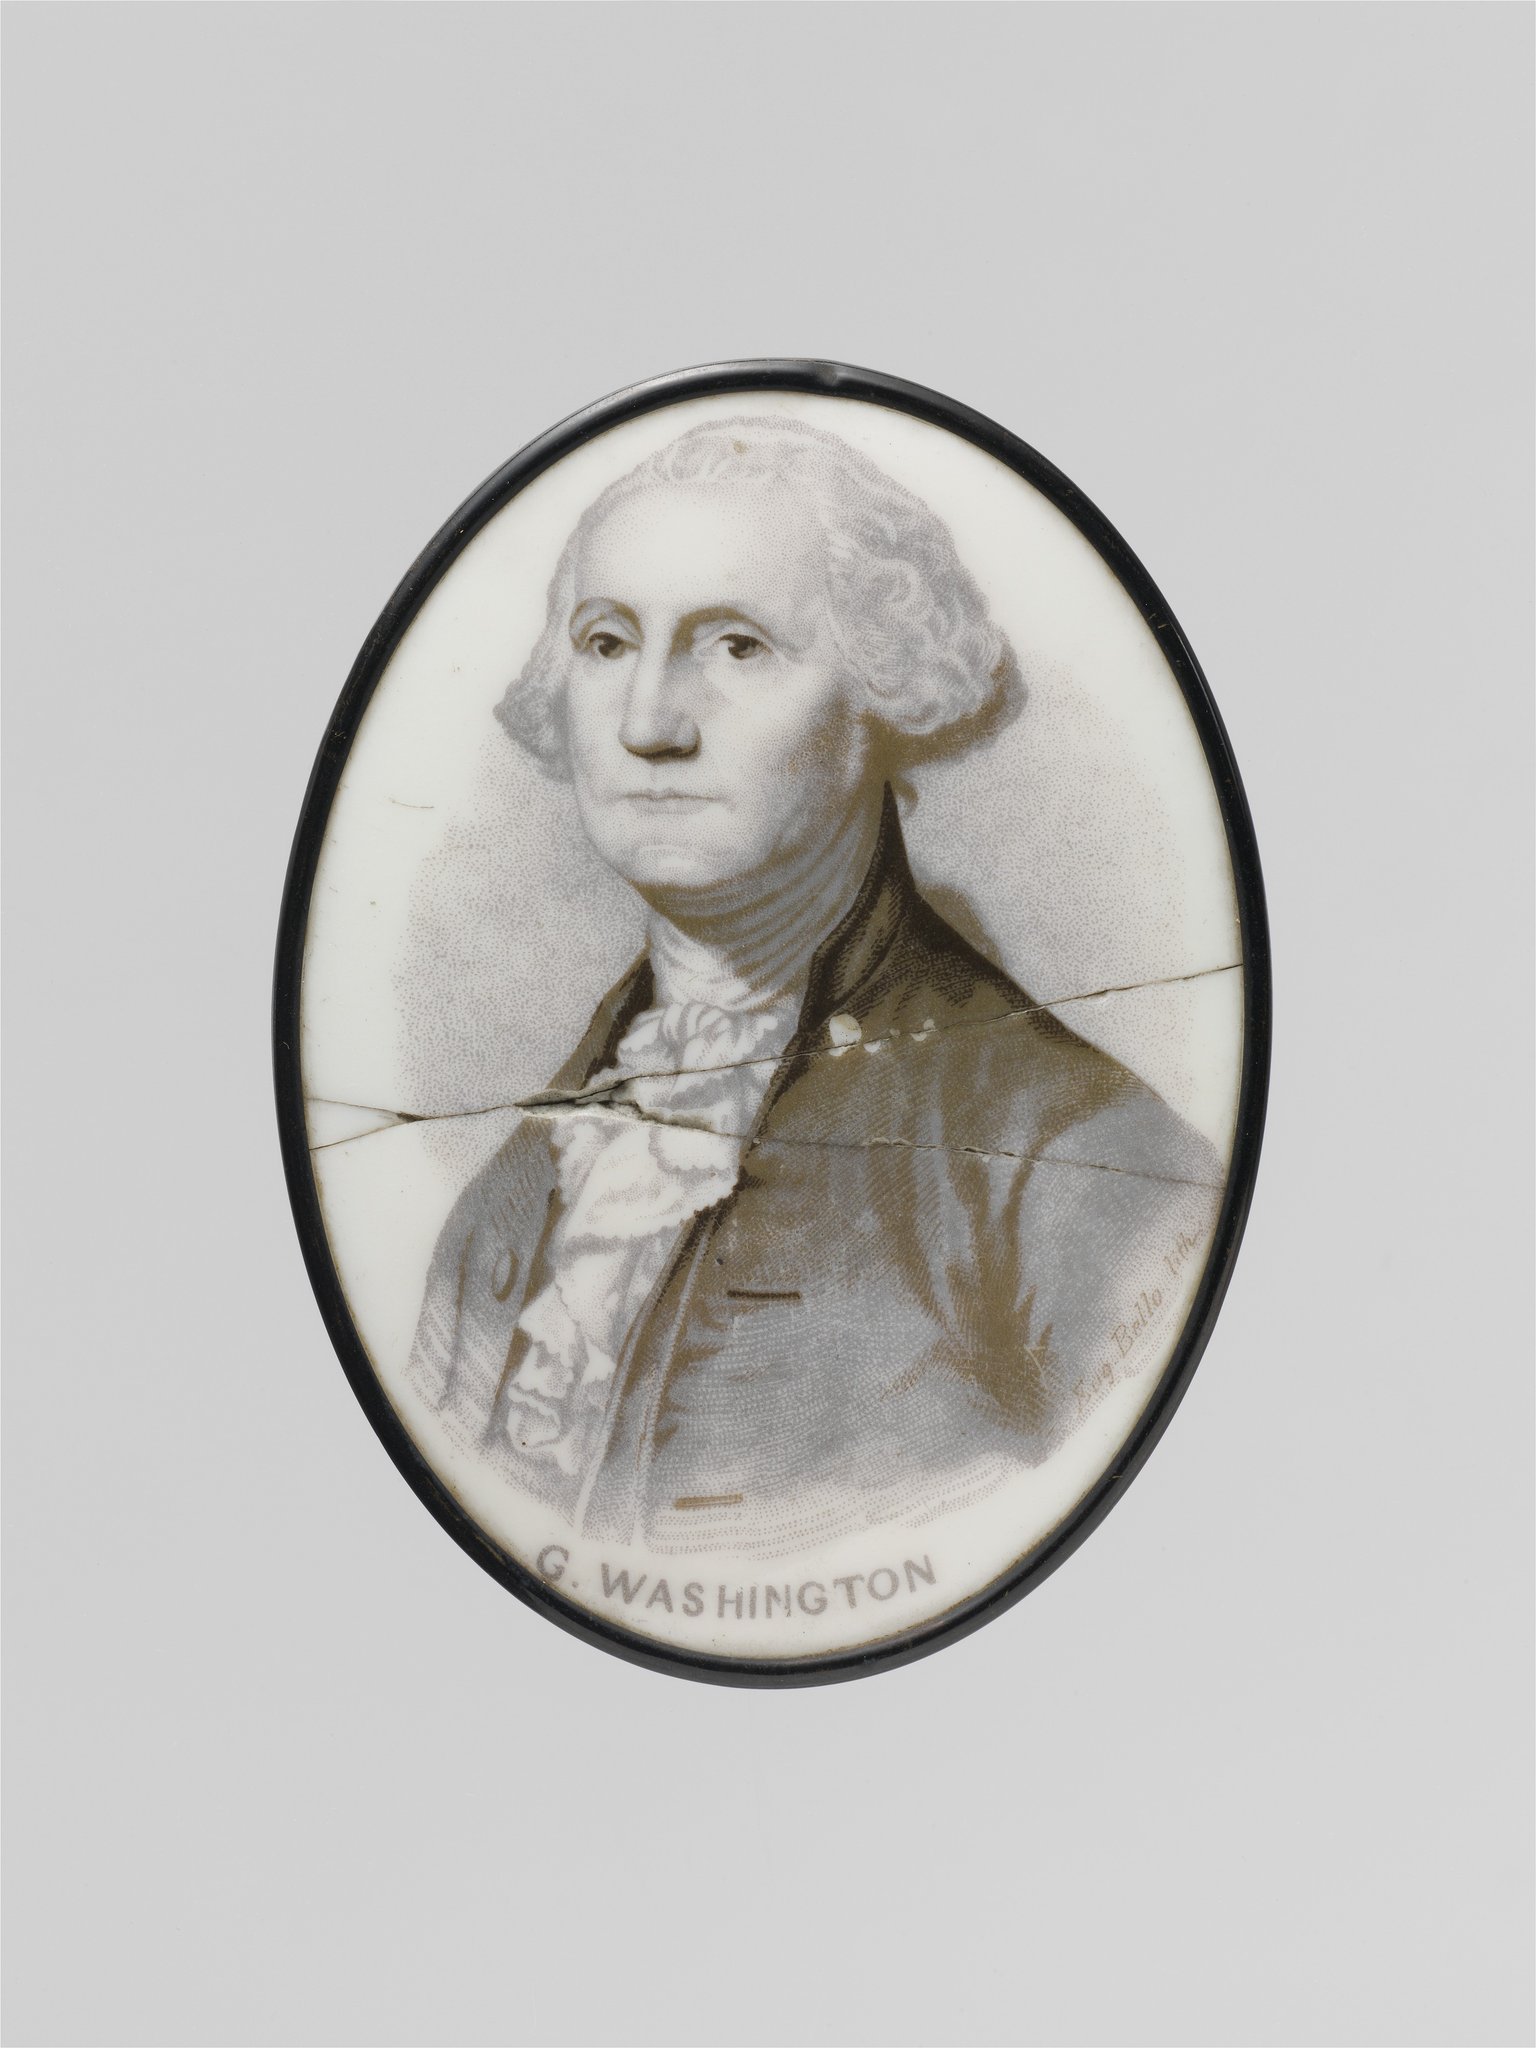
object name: plaque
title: George Washington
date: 1776-1783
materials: porcelain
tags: george washington,men,portraits